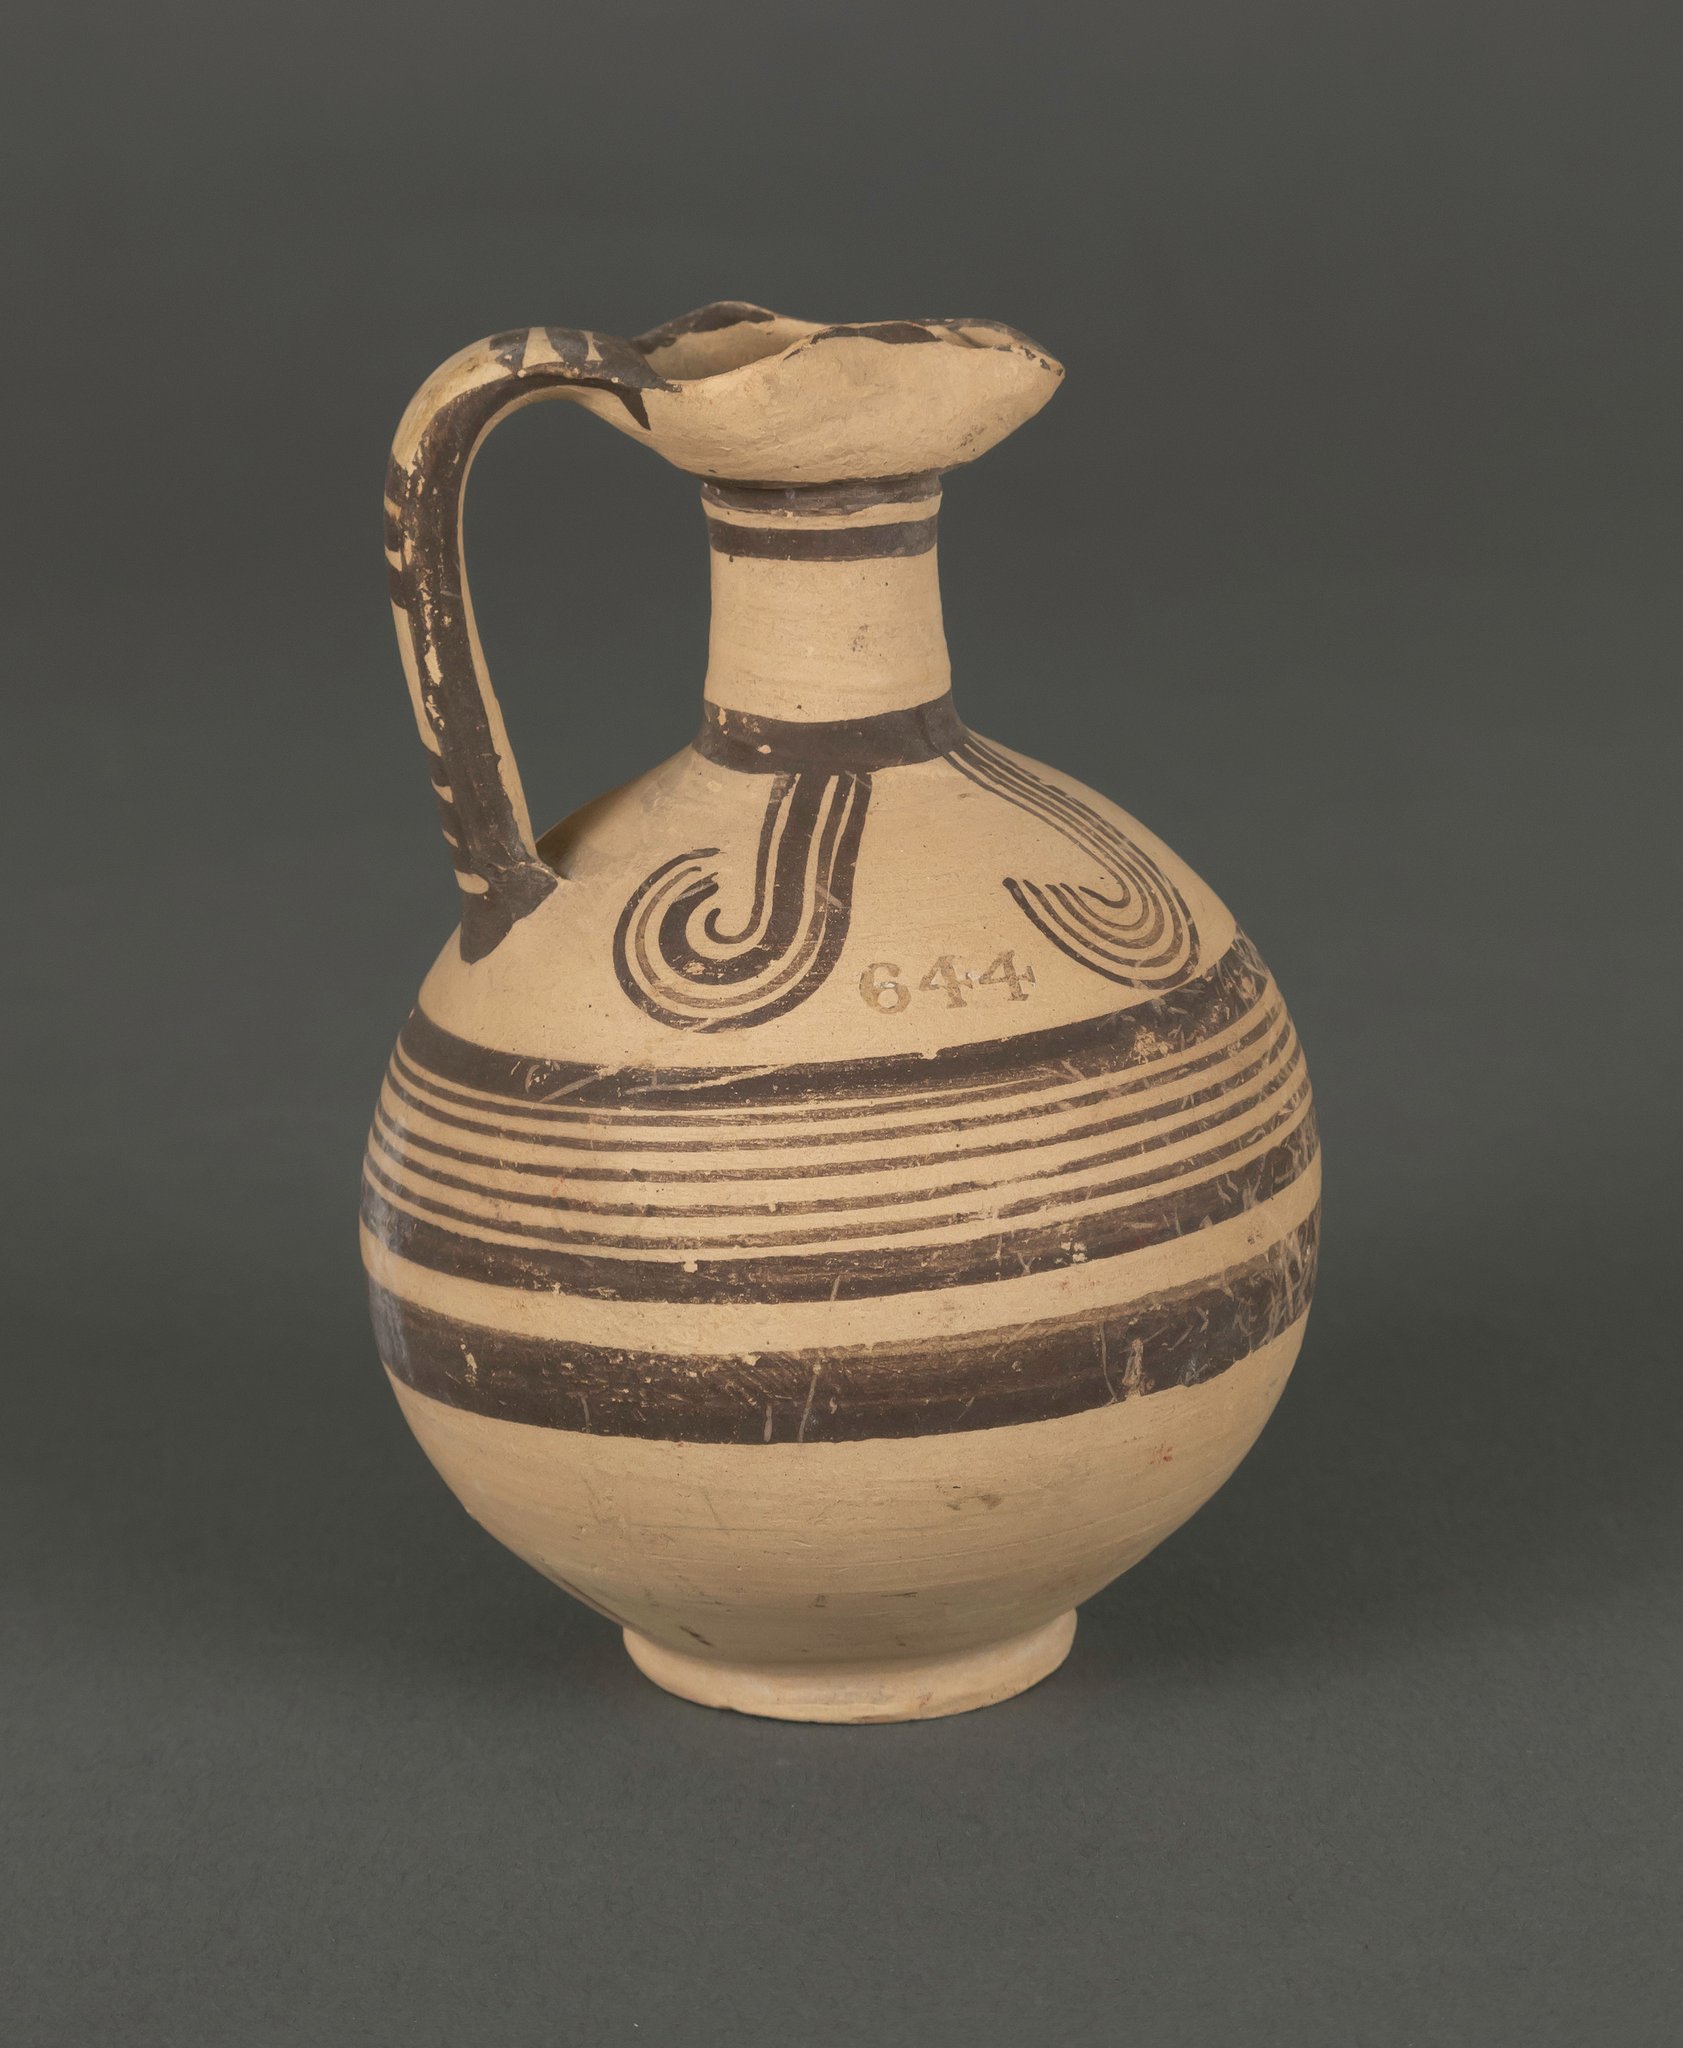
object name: juglet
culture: cypriot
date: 750-480 BCE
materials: terracotta